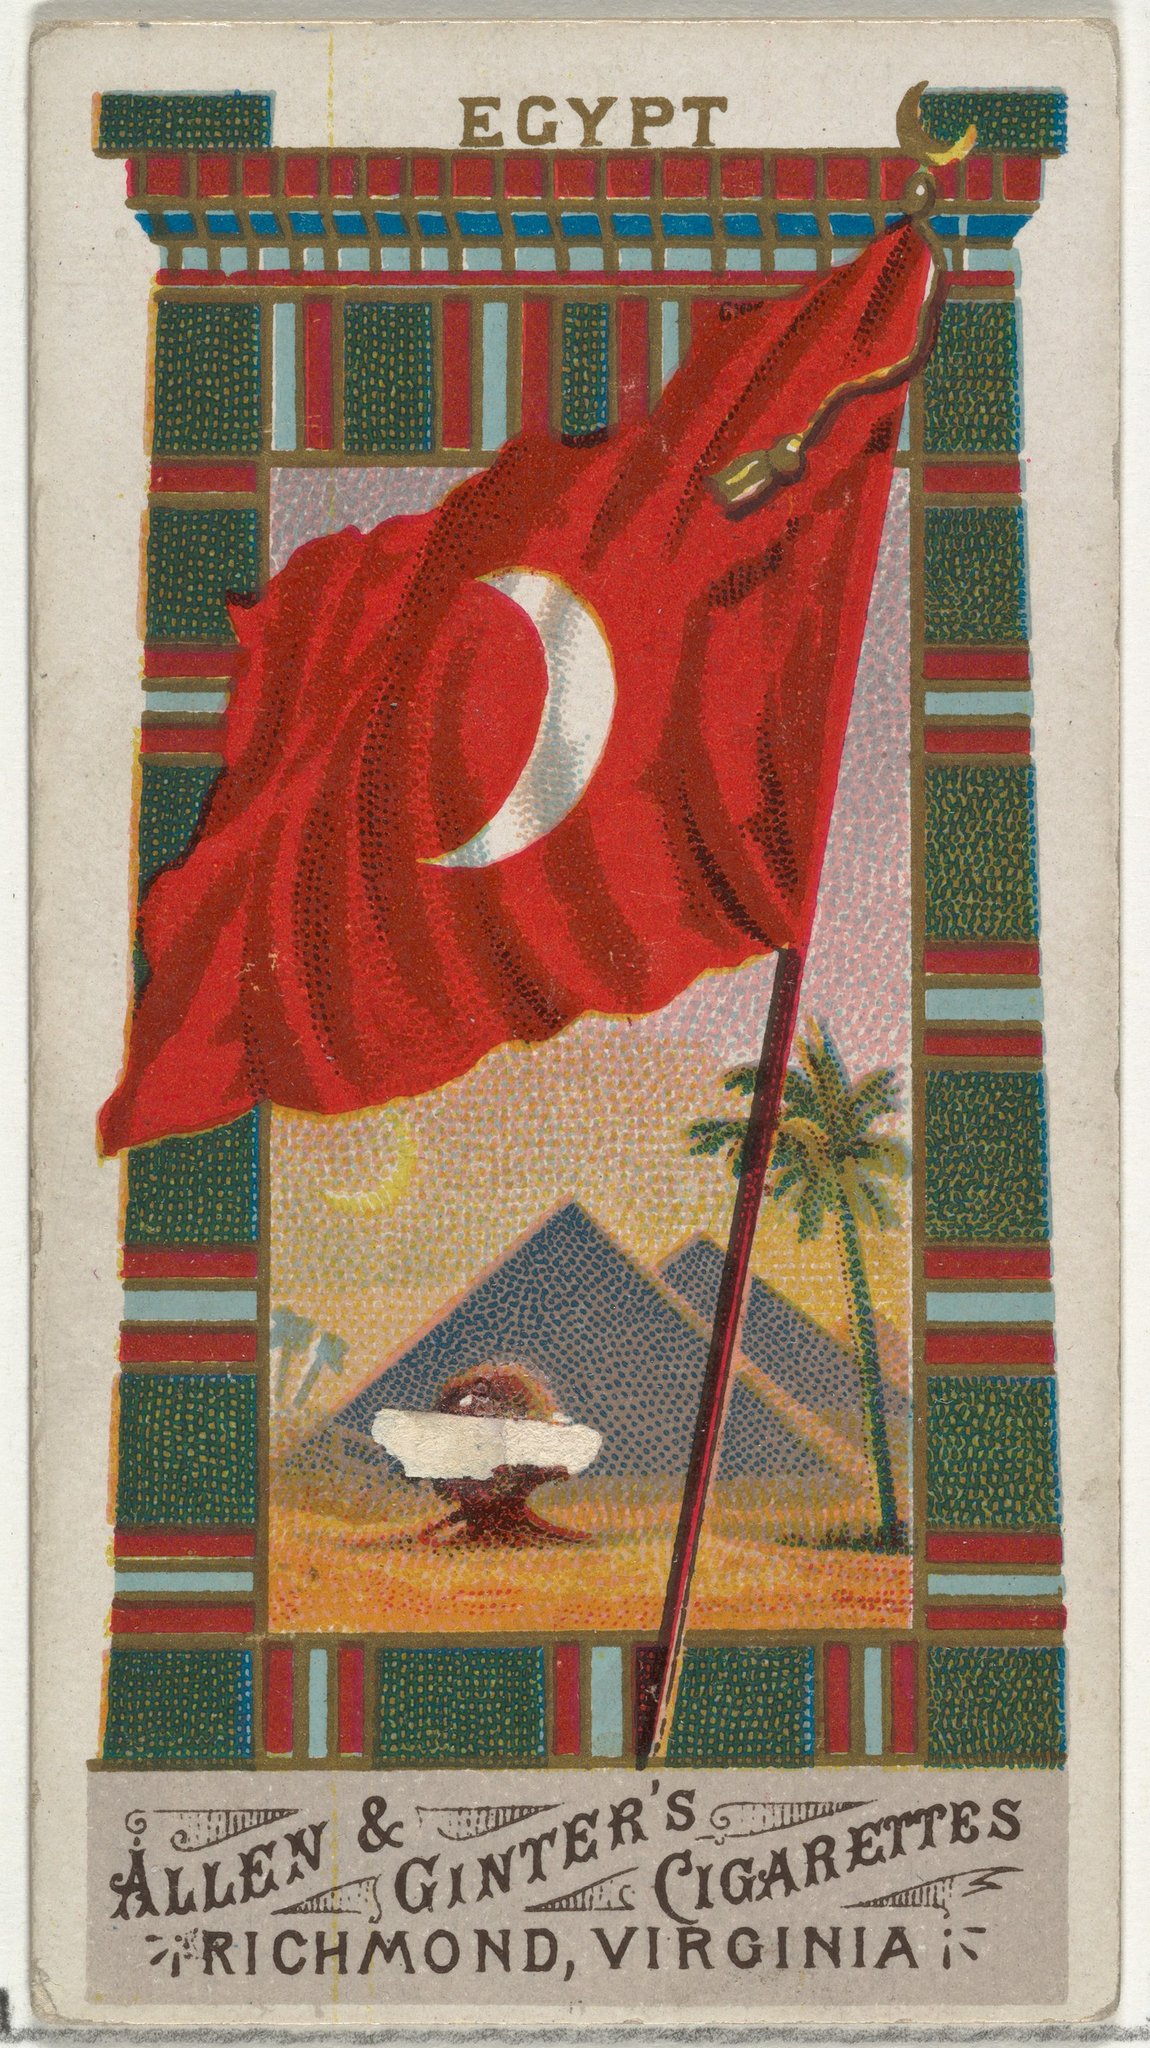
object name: print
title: Egypt, from Flags of All Nations, Series 1 (N9) for Allen & Ginter Cigarettes Brands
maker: allen & ginter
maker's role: publisher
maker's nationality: american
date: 1887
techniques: color lithograph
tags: flags